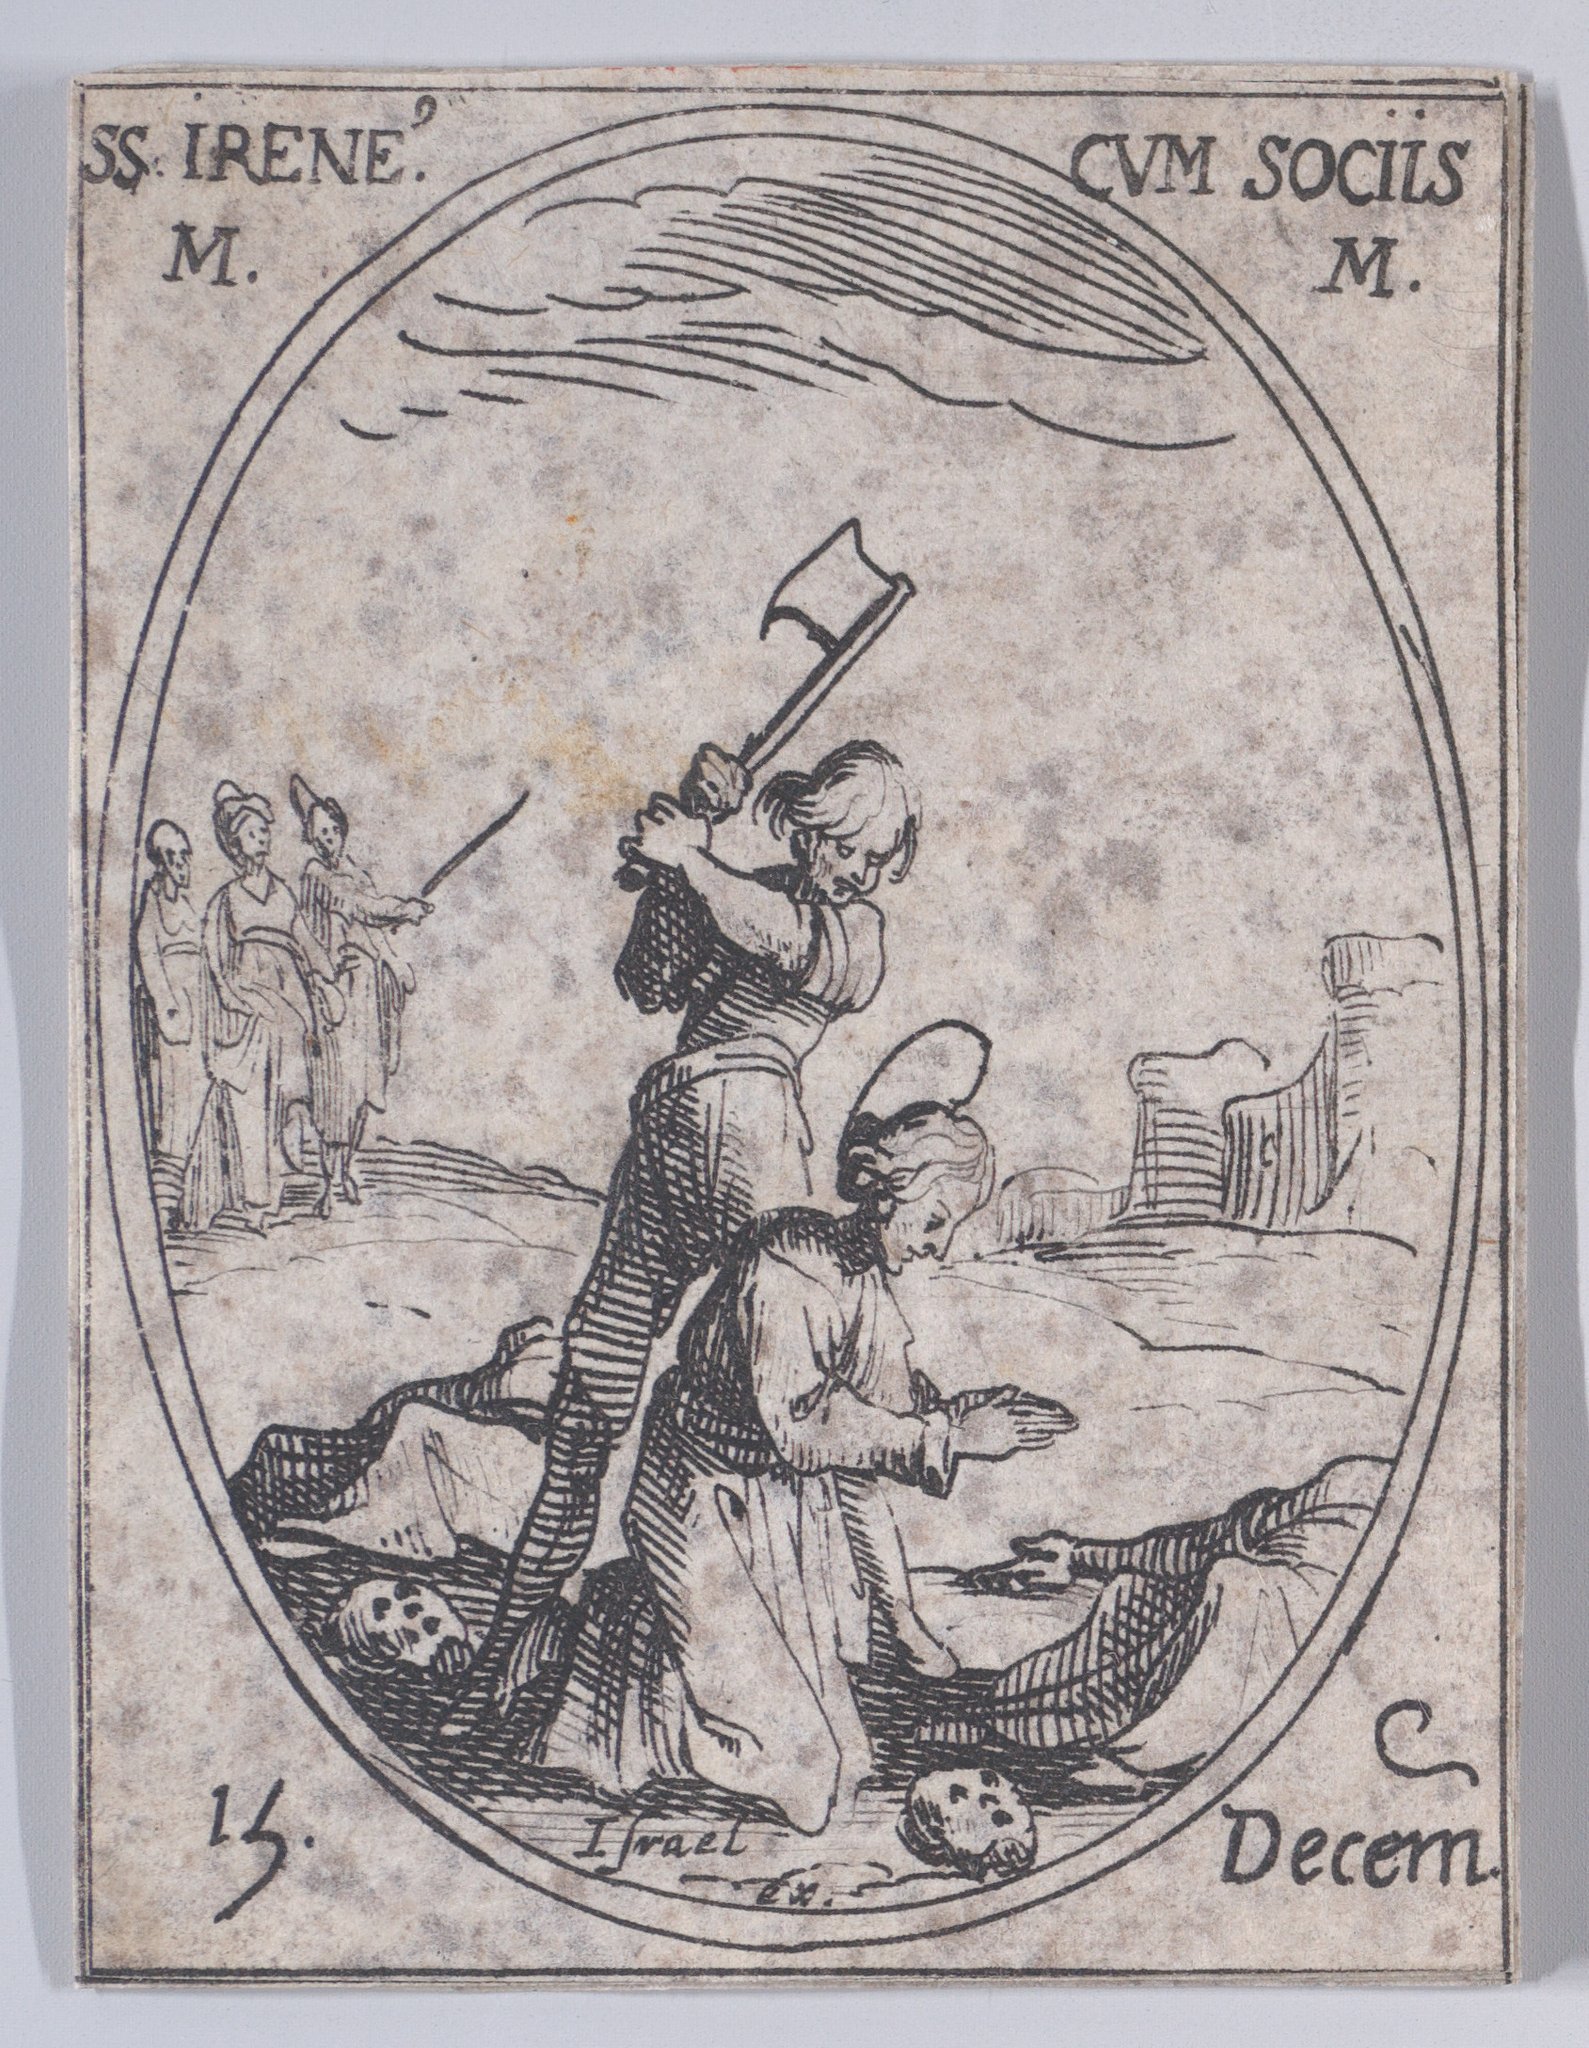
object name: print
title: S. Irénée et Ses Compagnons (St. Irenaeus and His Companions), December 15th, from "Les Images De Tous Les Saincts et Saintes de L'Année" (Images of All of the Saints and Religious Events of the Year)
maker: jacques callot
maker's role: artist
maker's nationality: french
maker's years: 1592-1635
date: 1636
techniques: etching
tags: men,saints